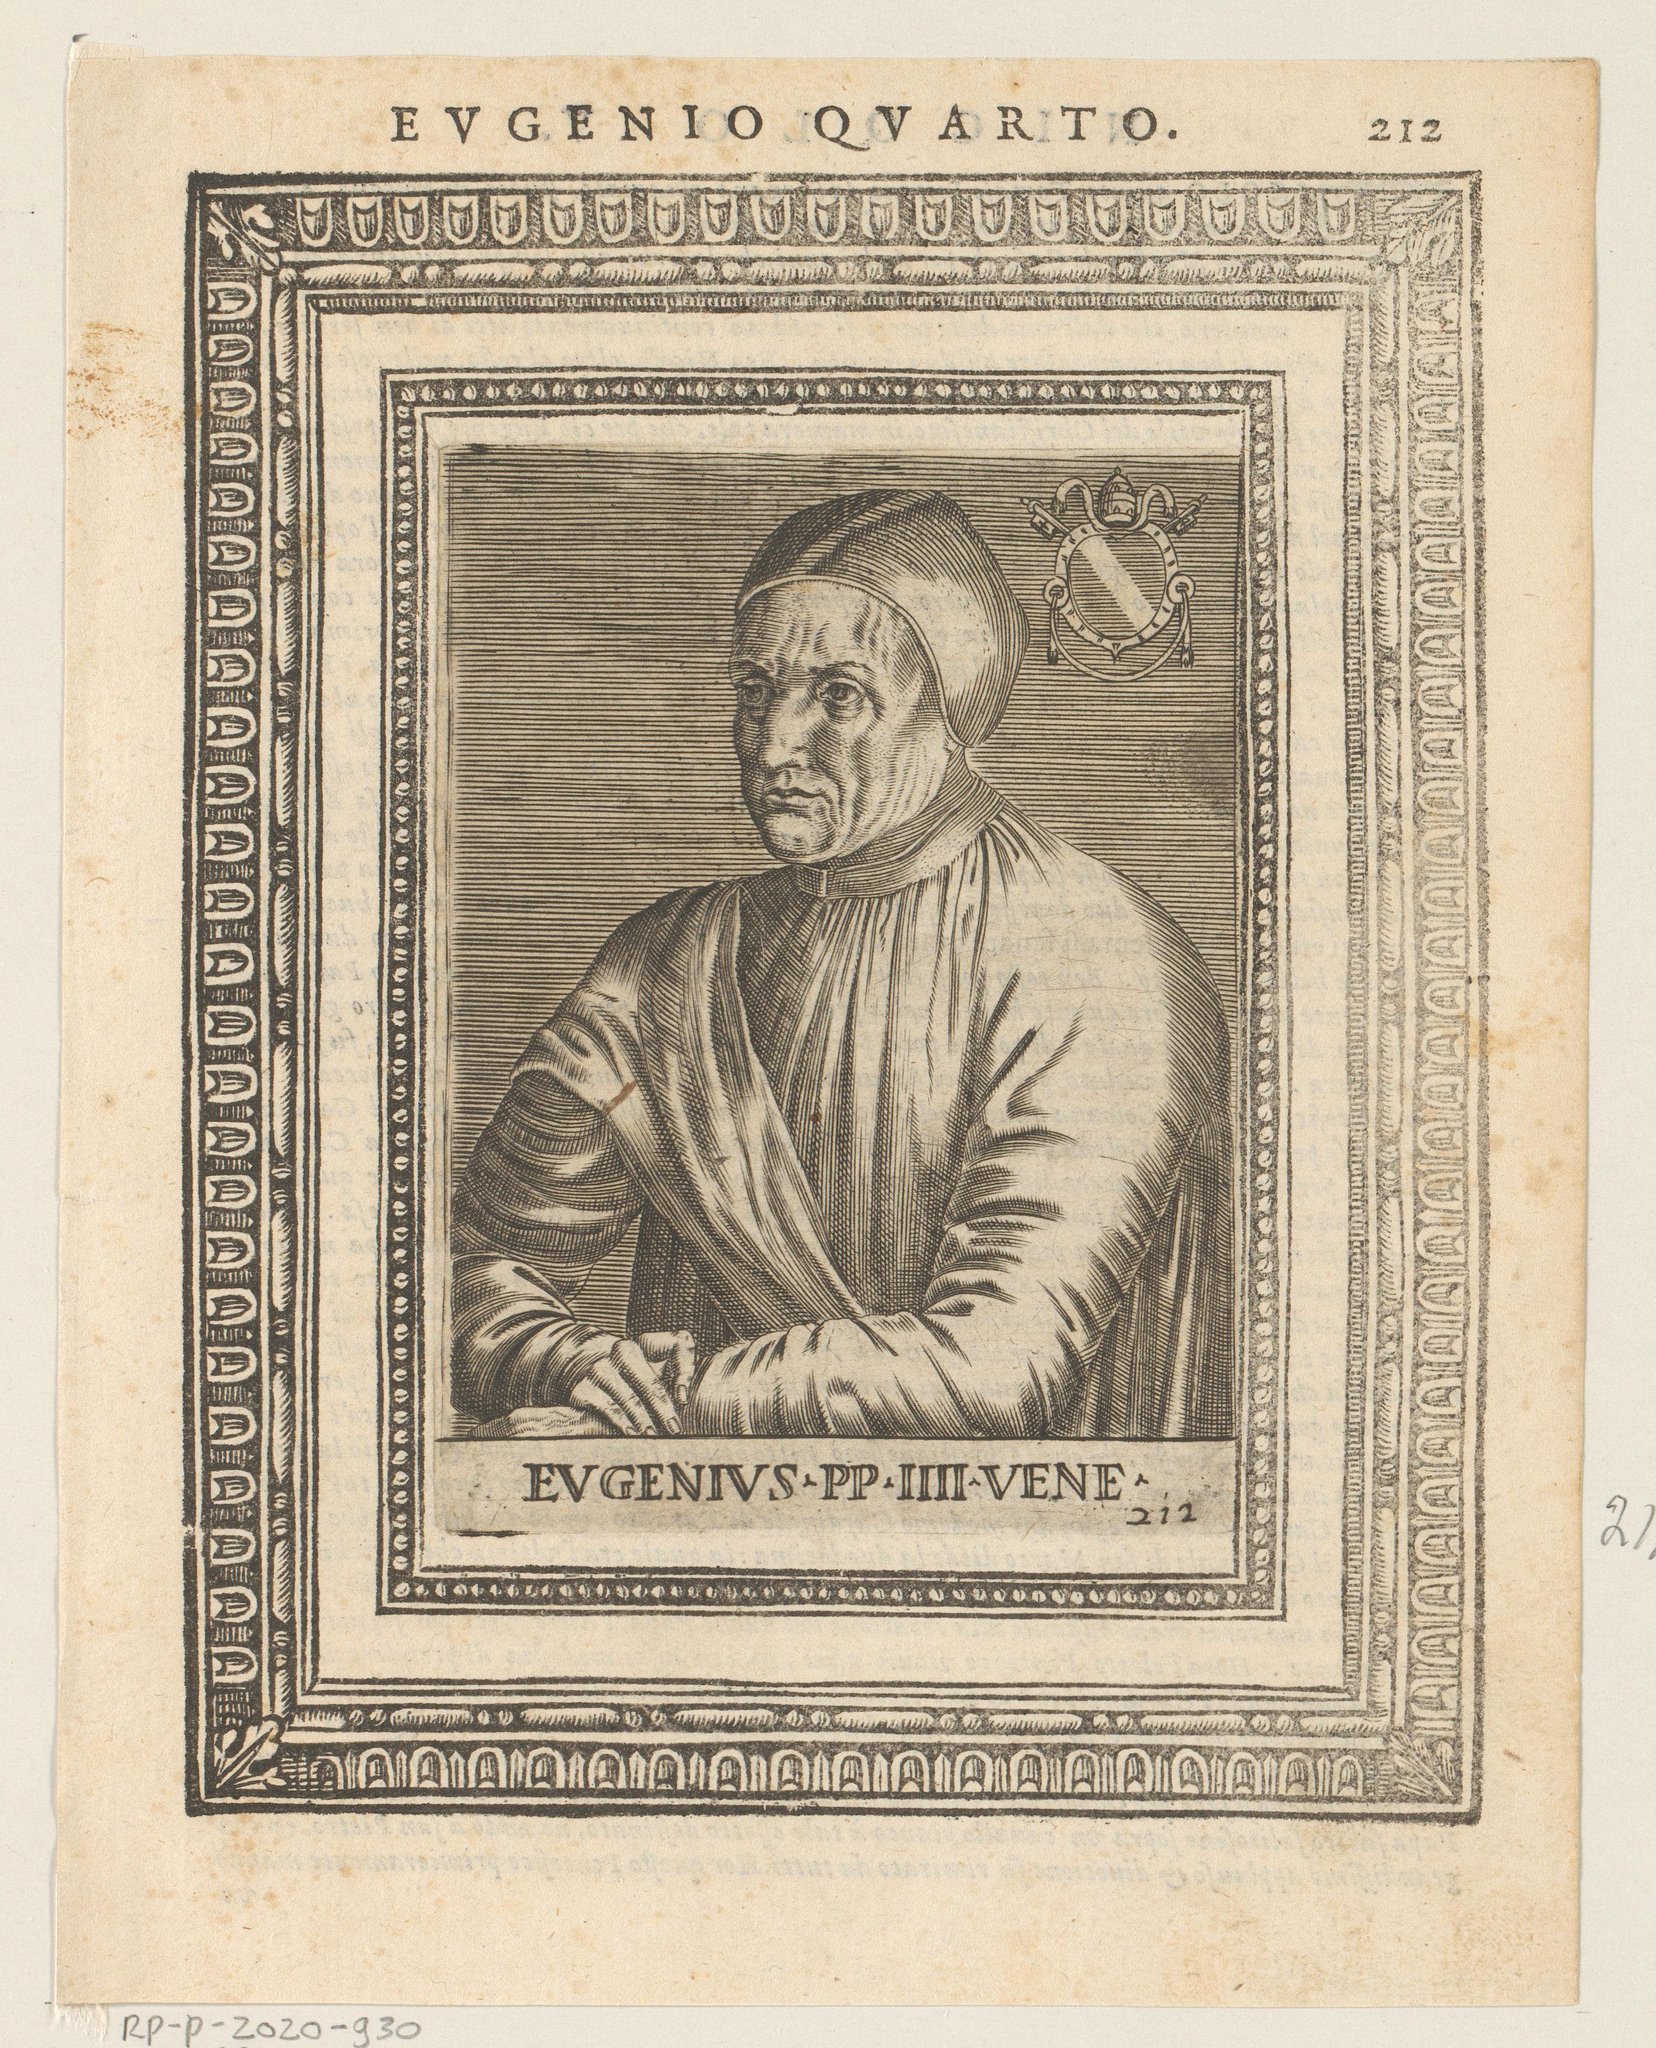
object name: book illustration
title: Portret van paus Eugenius IV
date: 1587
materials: paper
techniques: letterpress printing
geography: rome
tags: venice, historical persons, pope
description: Prent uit: Ciccarelli, Antonio. Le vite de Pontefici di Antonio Ciccarelli (...). Rome: Domenico Basa, 1587. Prent voor het eerst verschenen in: Cavalieri, Giovanni Battista de'. Pontificum romanorum effigies (...). Rome: Domenico Basa en Francesco Zanetti, 1580. Prent ook gebruikt in latere publicaties.